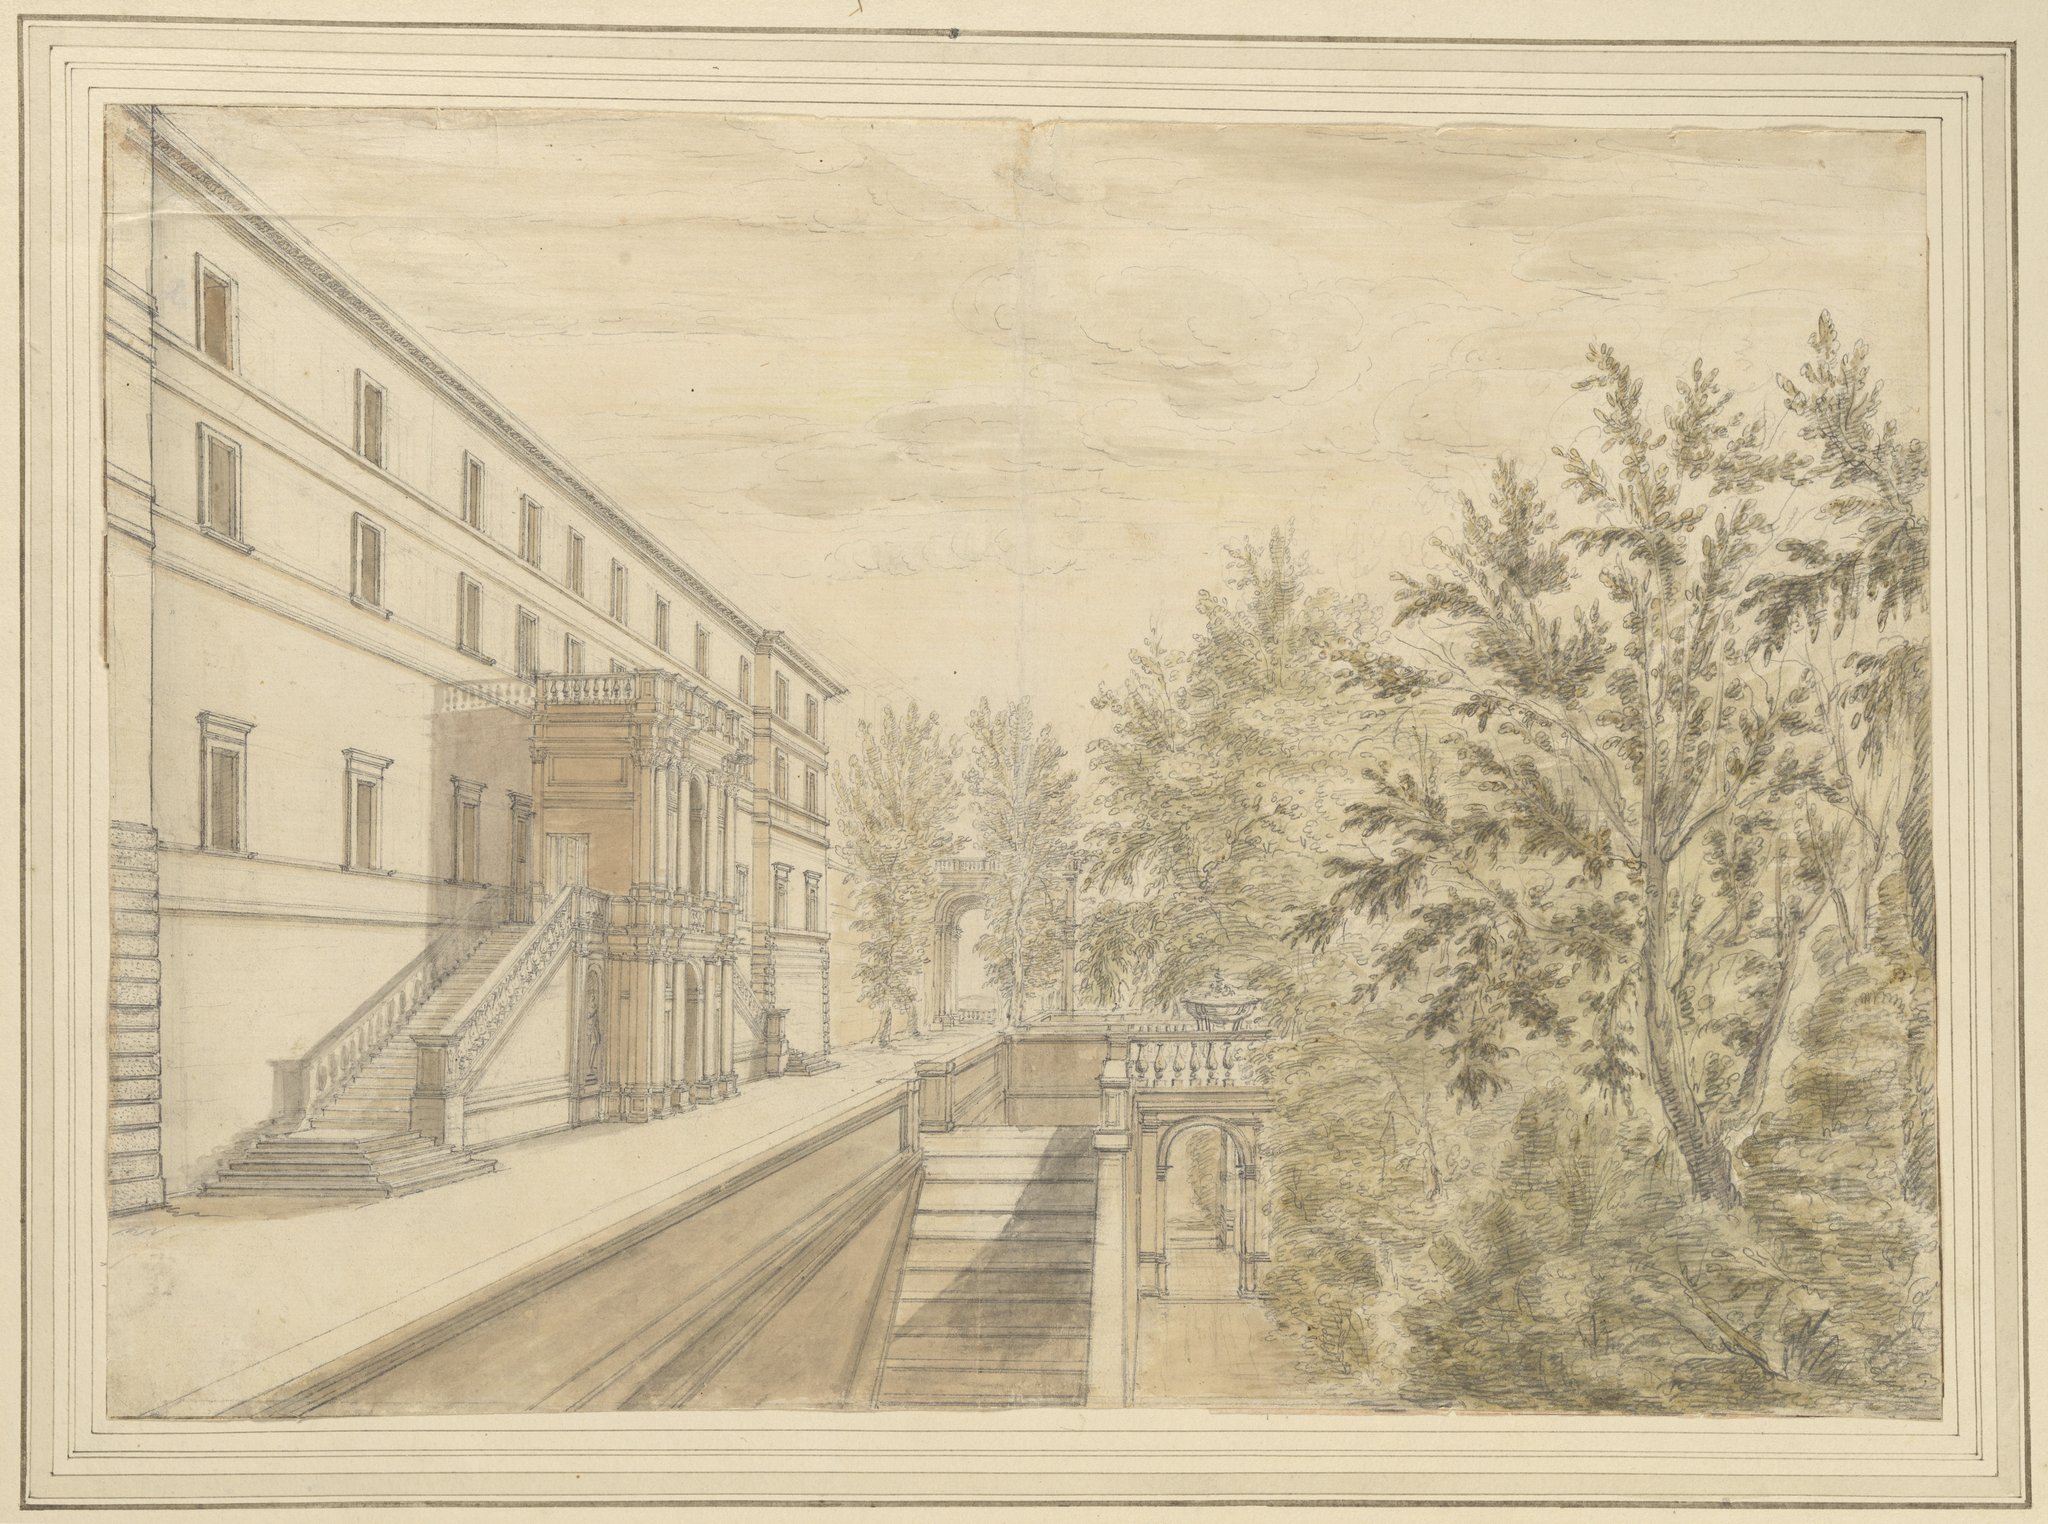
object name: drawing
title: View of the Garden Terrace of the Villa d'Este at Tivoli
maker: israël silvestre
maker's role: artist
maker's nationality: french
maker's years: 1621-1691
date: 1643-1644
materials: ink, pencil, watercolor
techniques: wash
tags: buildings,gardens